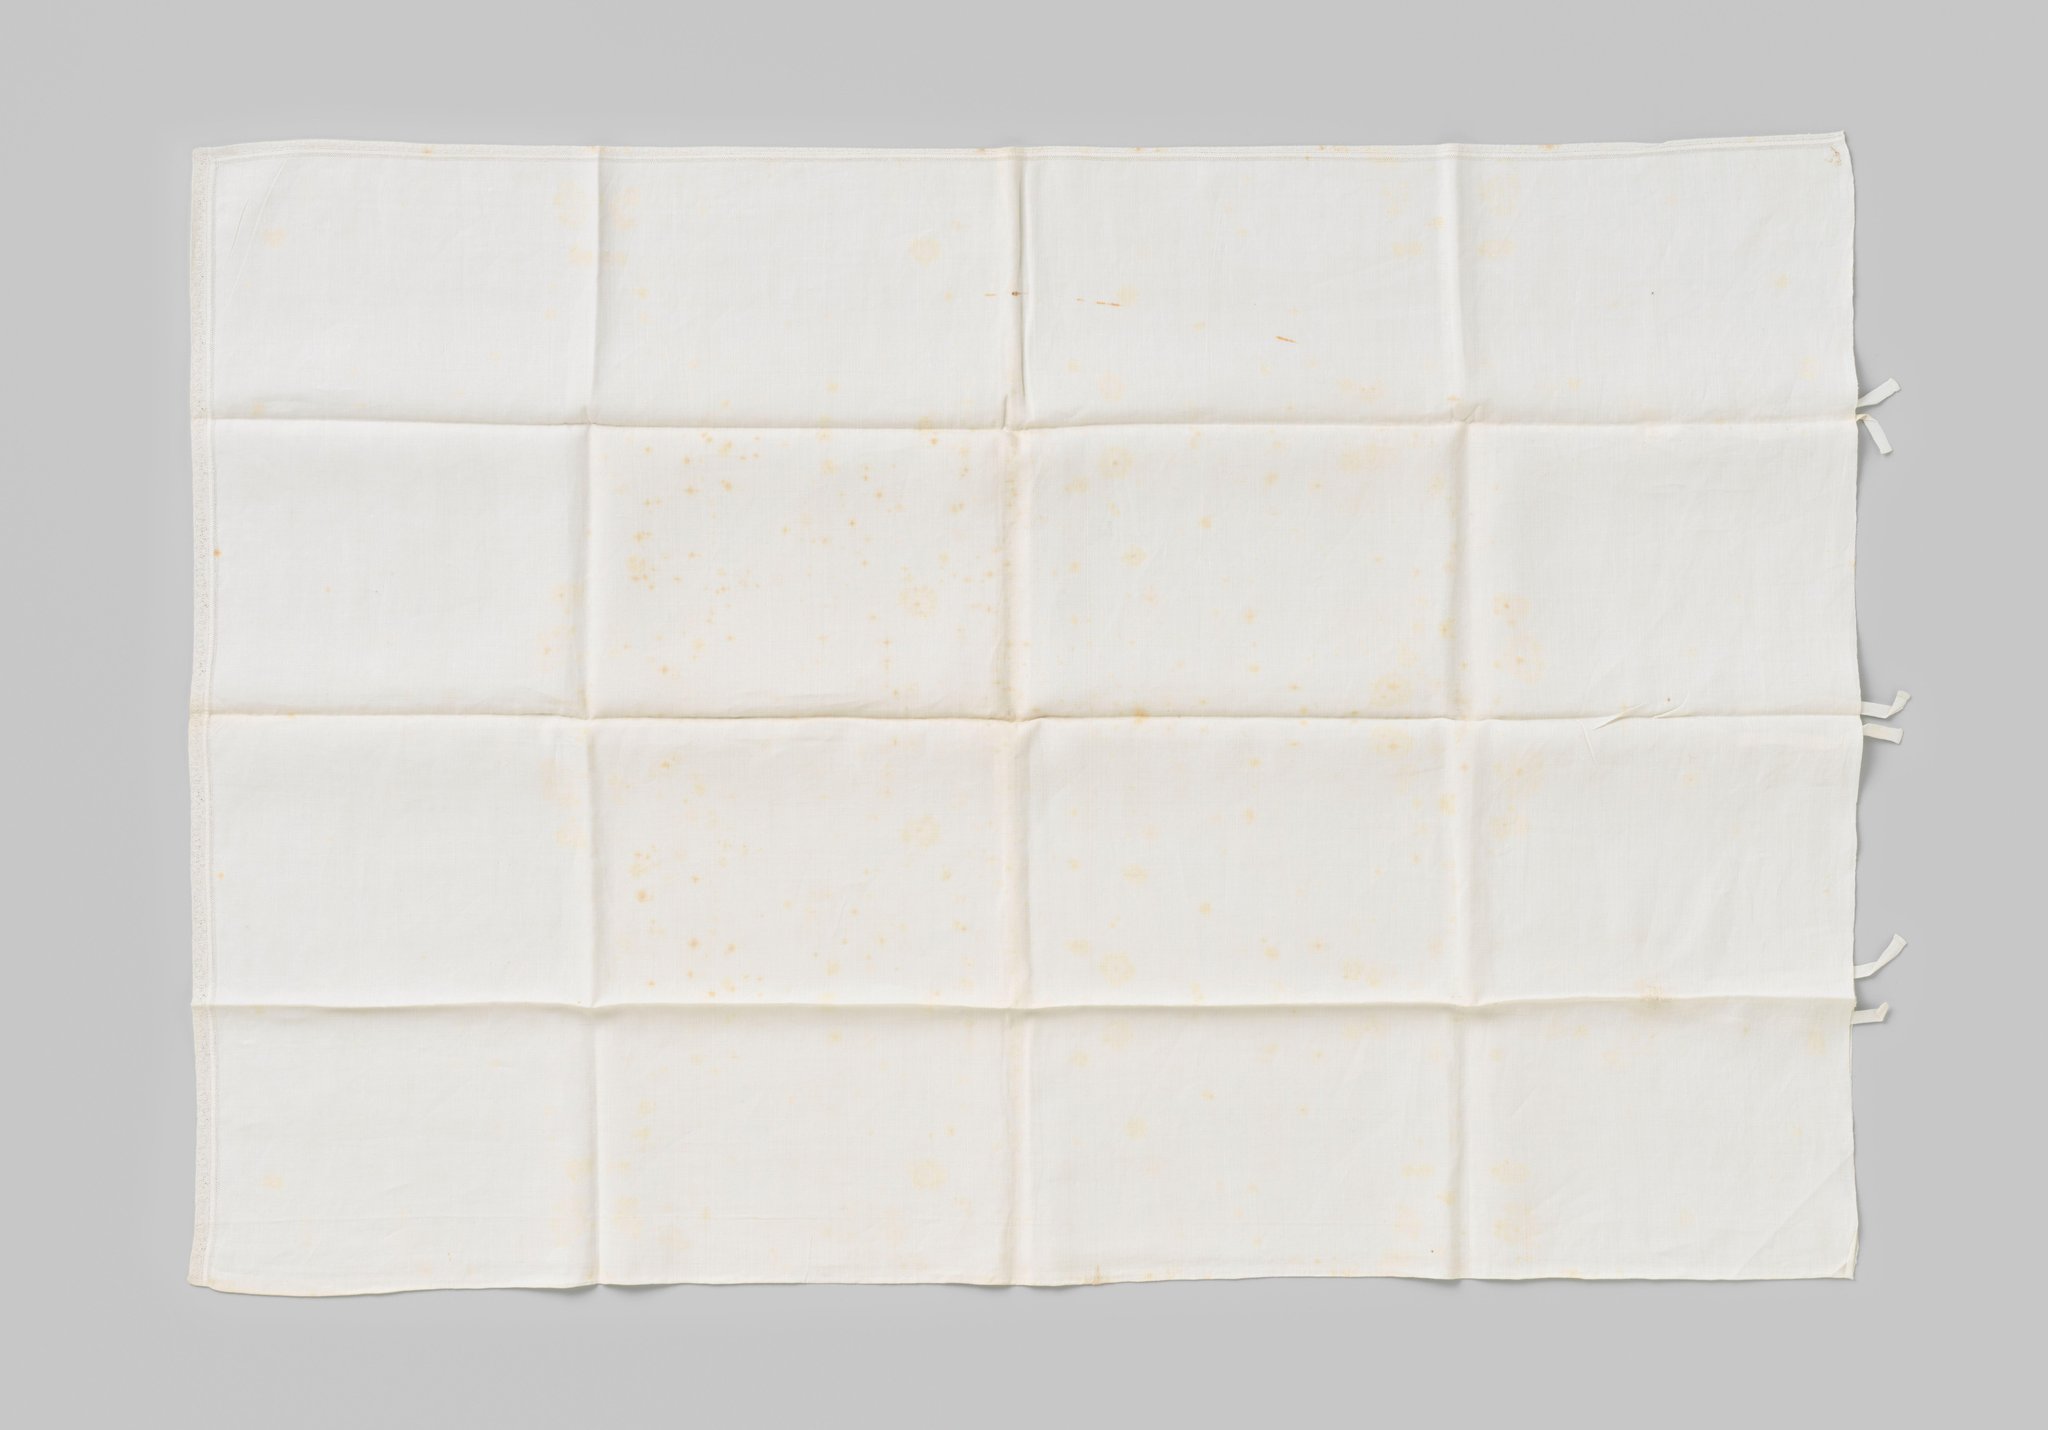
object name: pillowcase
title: Kussensloop met tussenzetsel van kloskant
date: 1600-1799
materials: linen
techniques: lace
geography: netherlands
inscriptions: mark: ‘AvB3’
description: Twee kussenslopen (BK-1994-27-A en B) met tussenzetsel van kloskant en geborduurd in bruin met resp. AvB2 en AvB3.